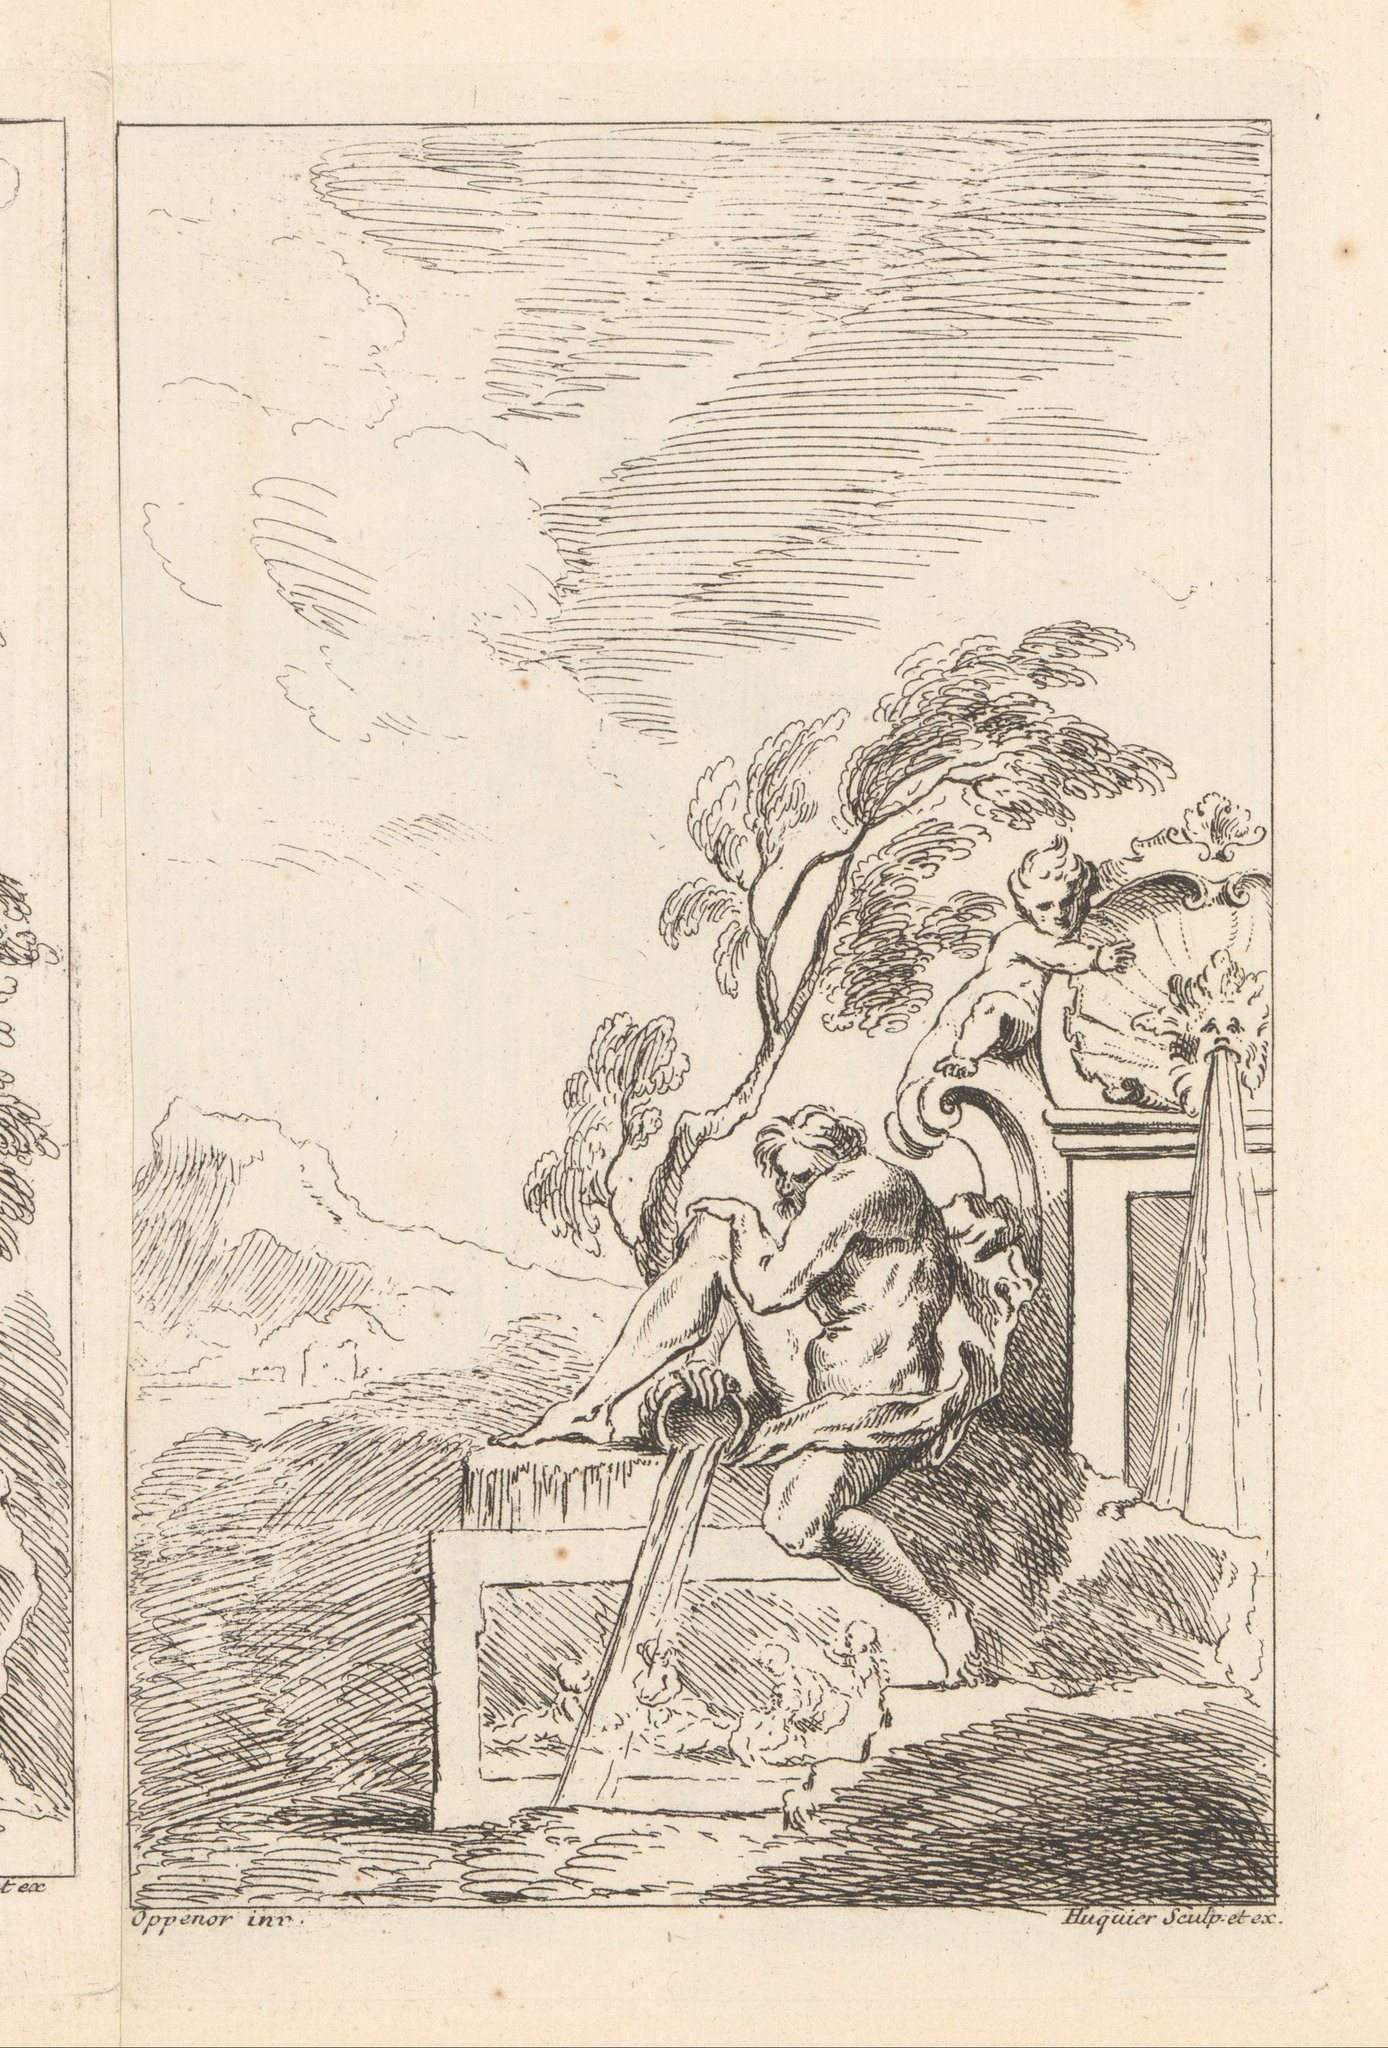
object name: album leaf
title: Nouveau livre de fontaines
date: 1725-1750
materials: paper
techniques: etching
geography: paris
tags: garden fountain, ornamental fountain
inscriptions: collector's mark: Lugt 2228a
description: De prenten van deze reeks zijn telkens per twee aan elkaar geplakt om in het boek mee te binden met hetzelfde formaat als de voorgaande bladen.